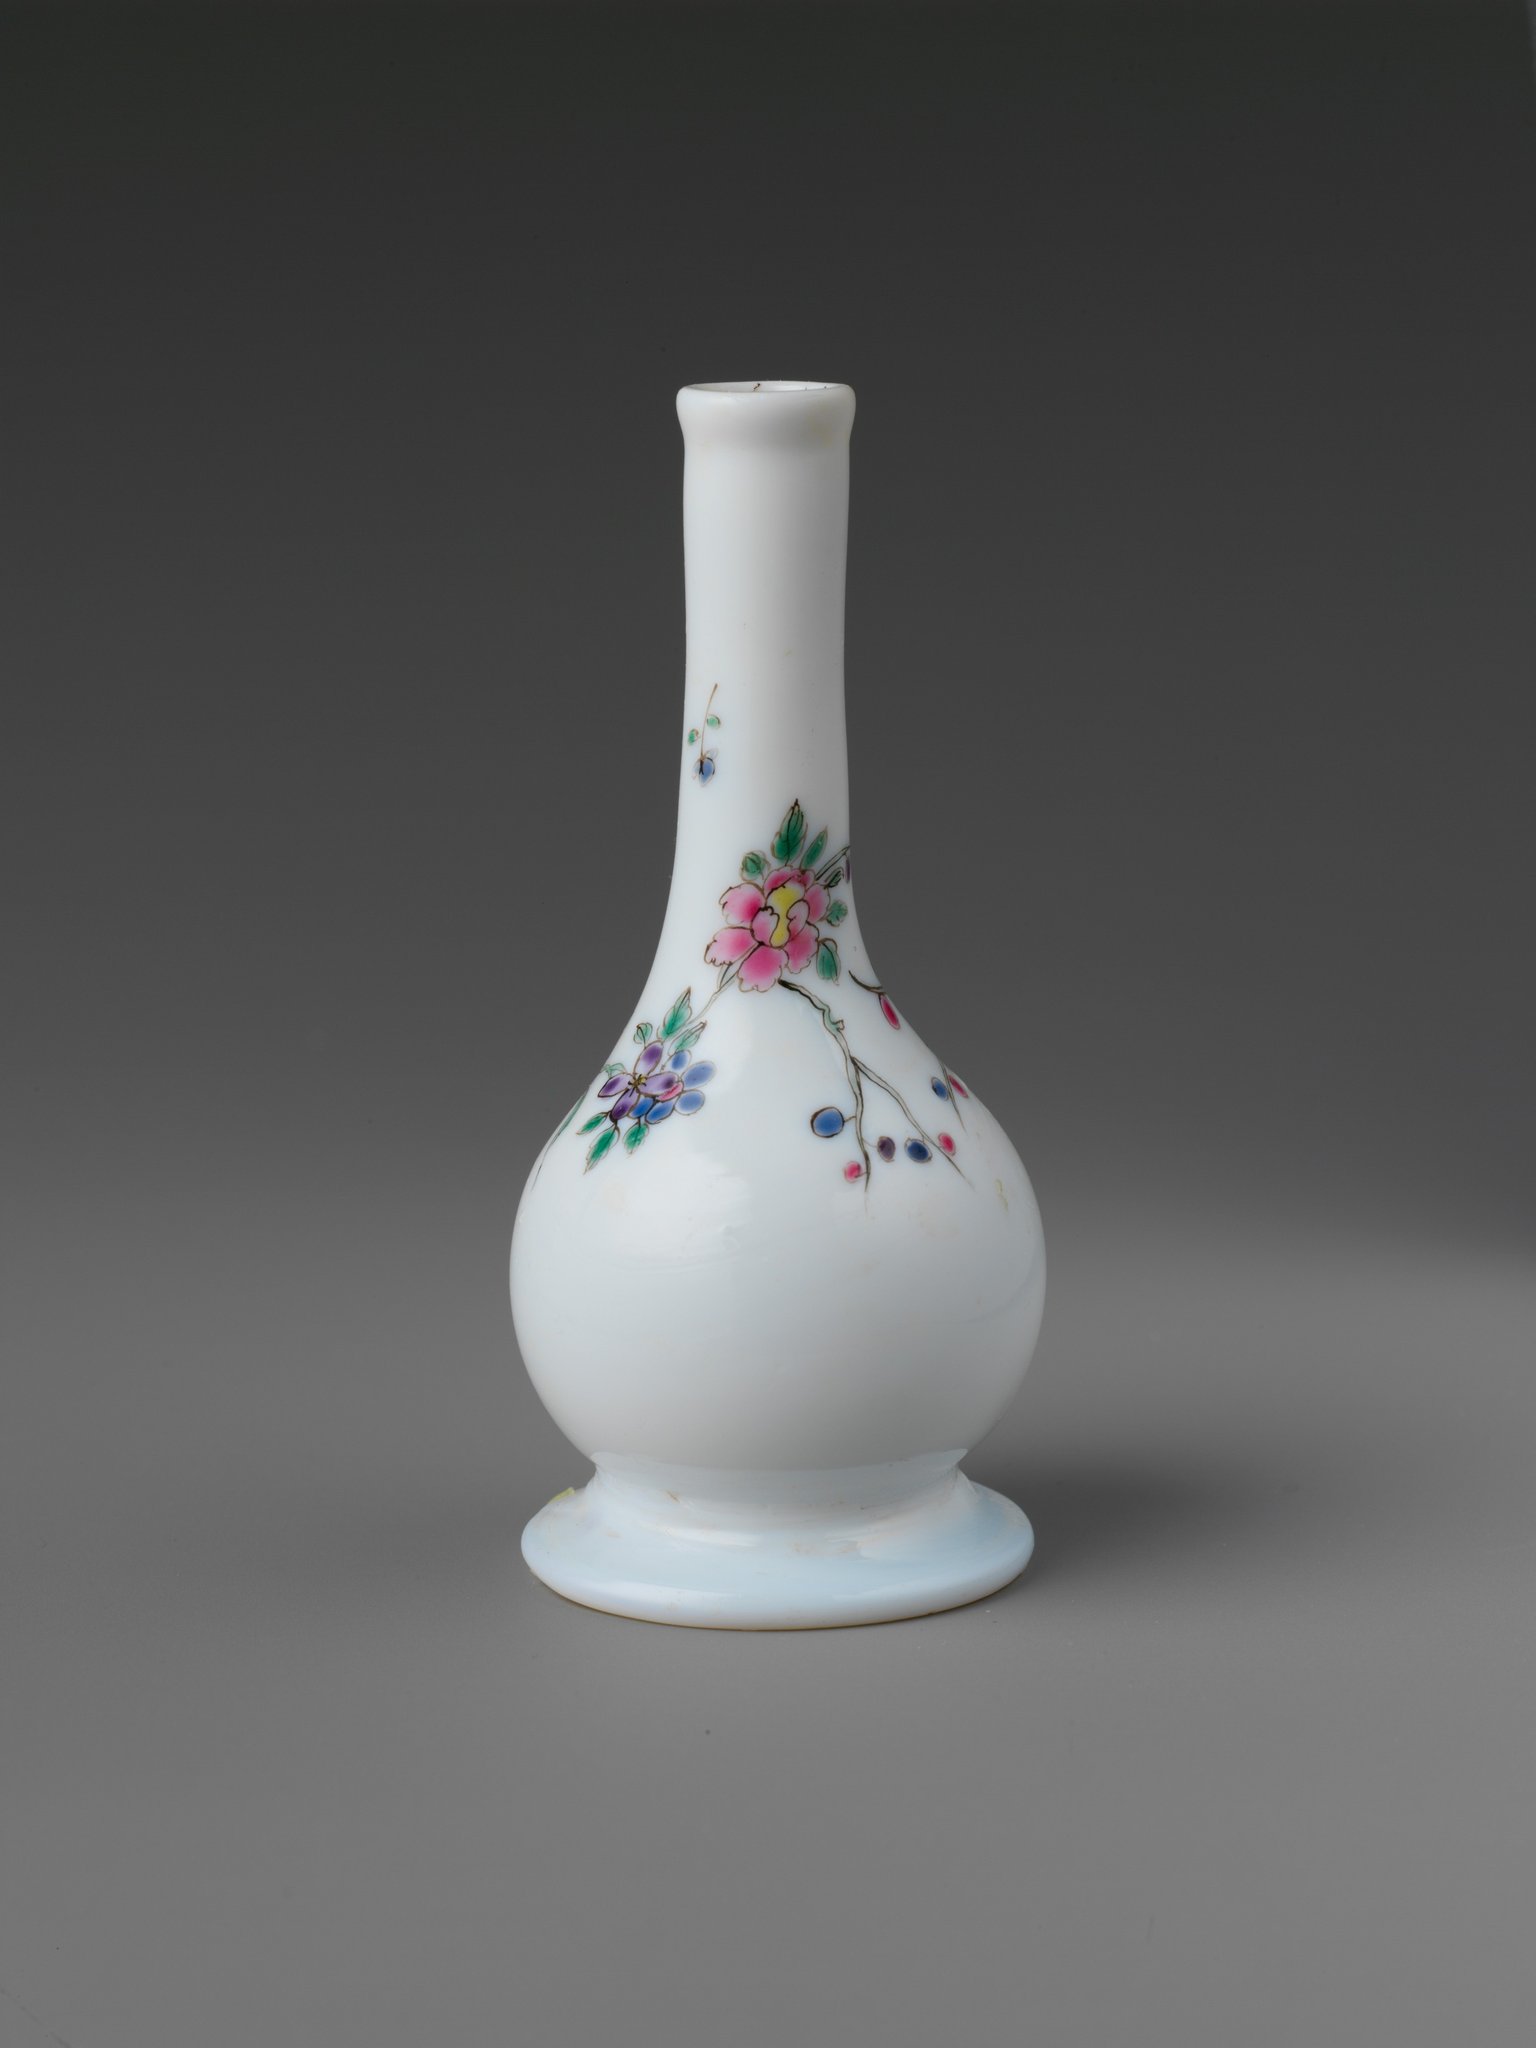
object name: bottle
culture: british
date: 1760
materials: enamel, glass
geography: england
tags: flowers